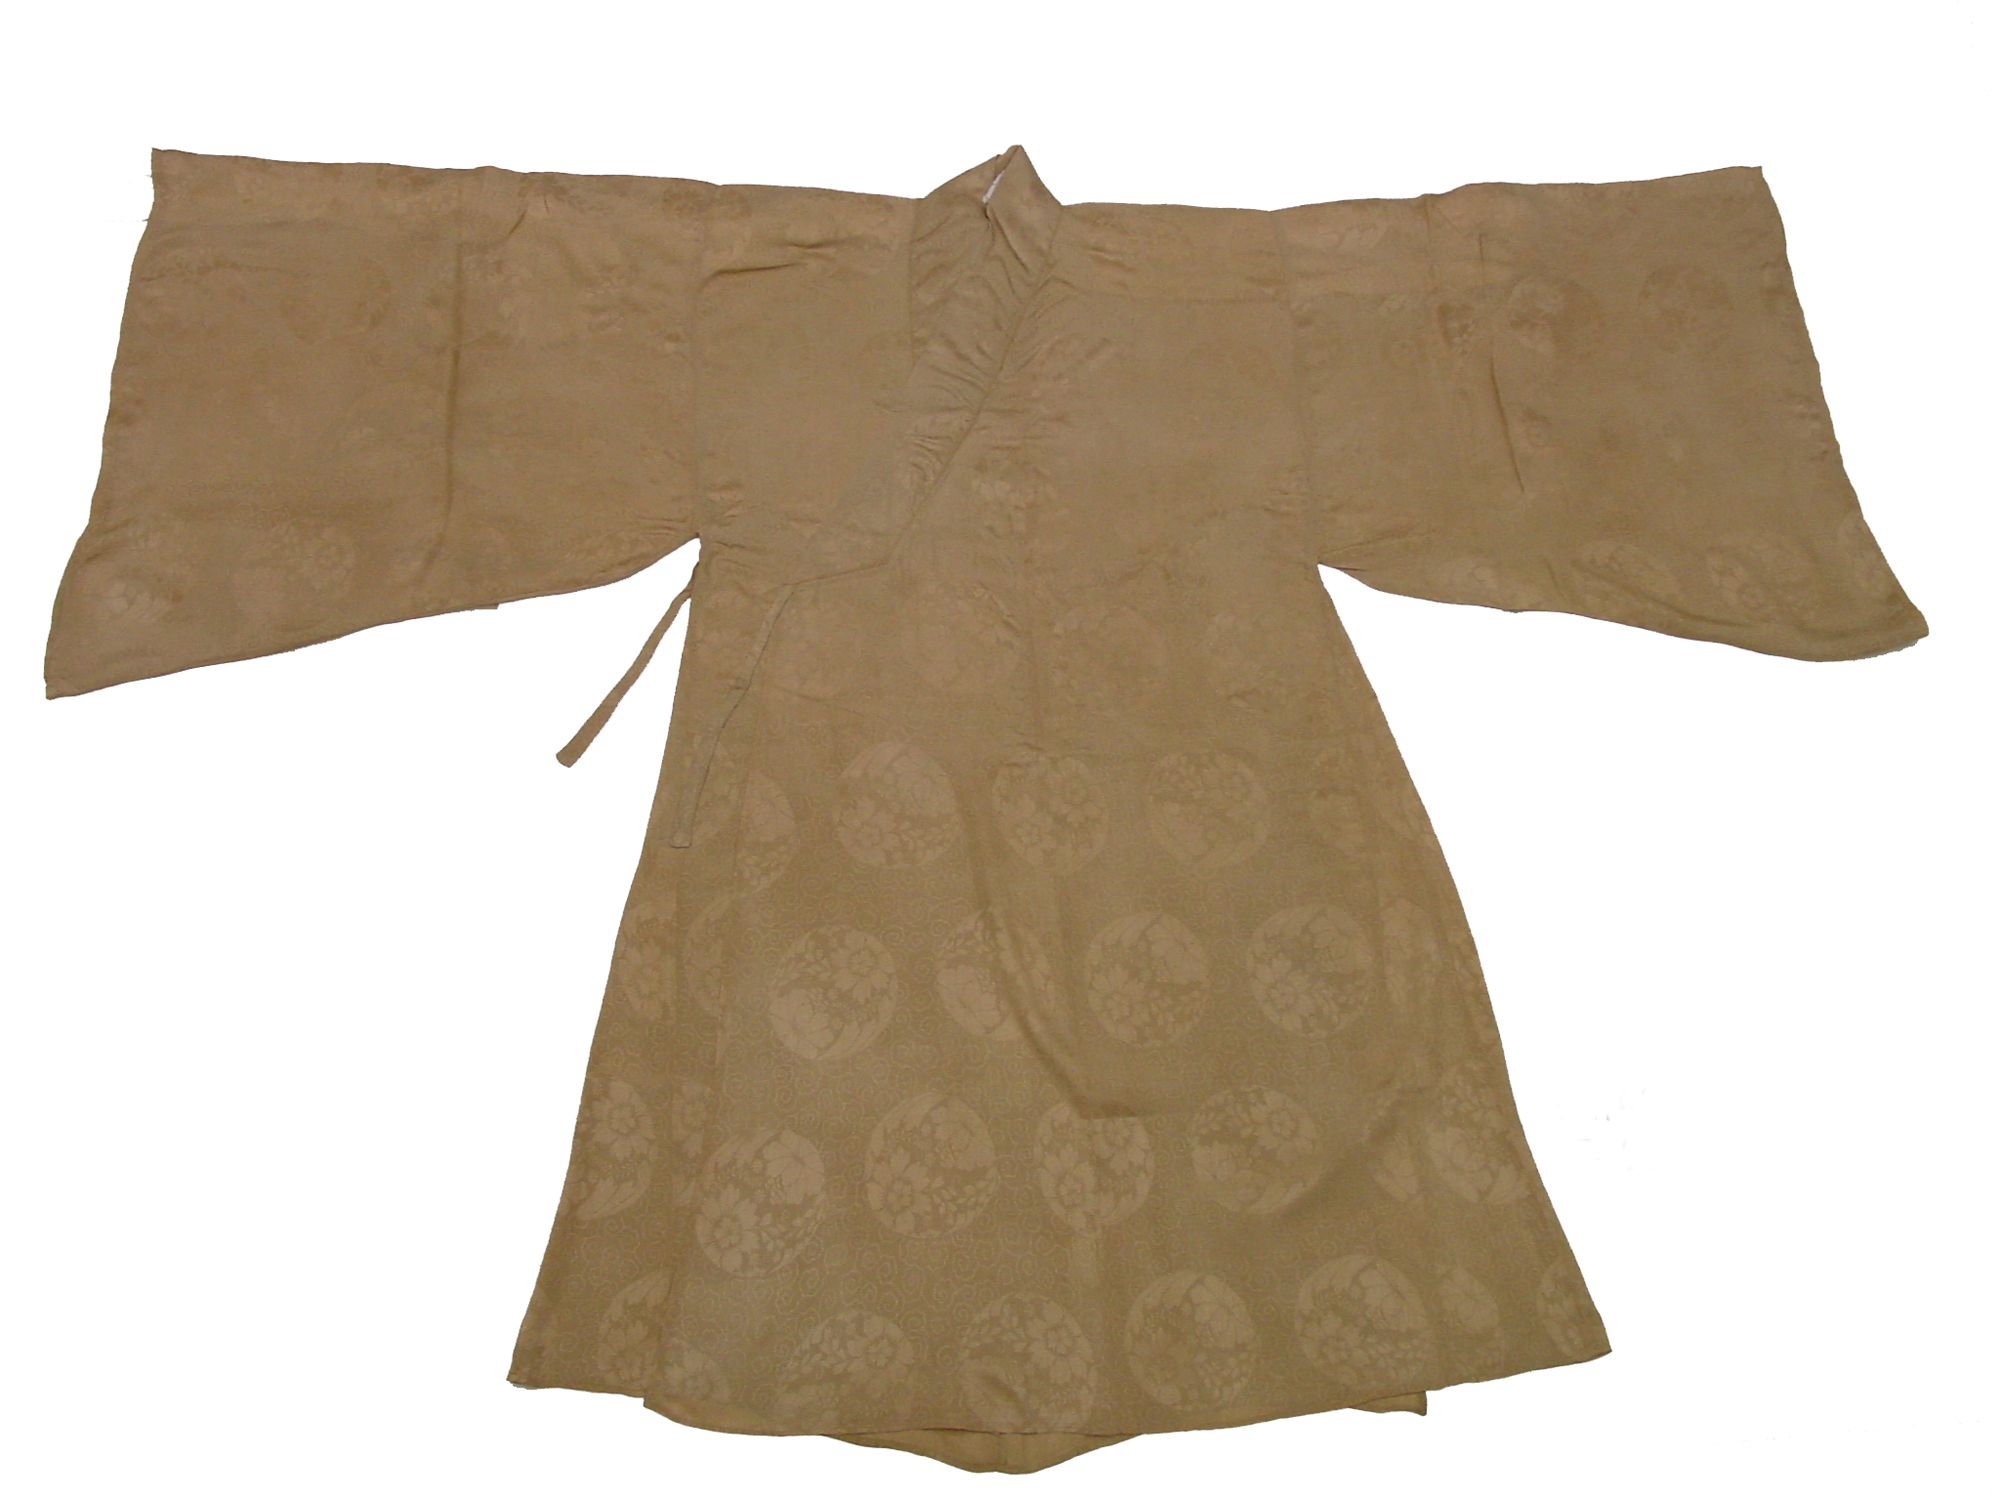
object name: robe, priest's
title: Priest's Robe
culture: chinese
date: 1901-2000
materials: silk